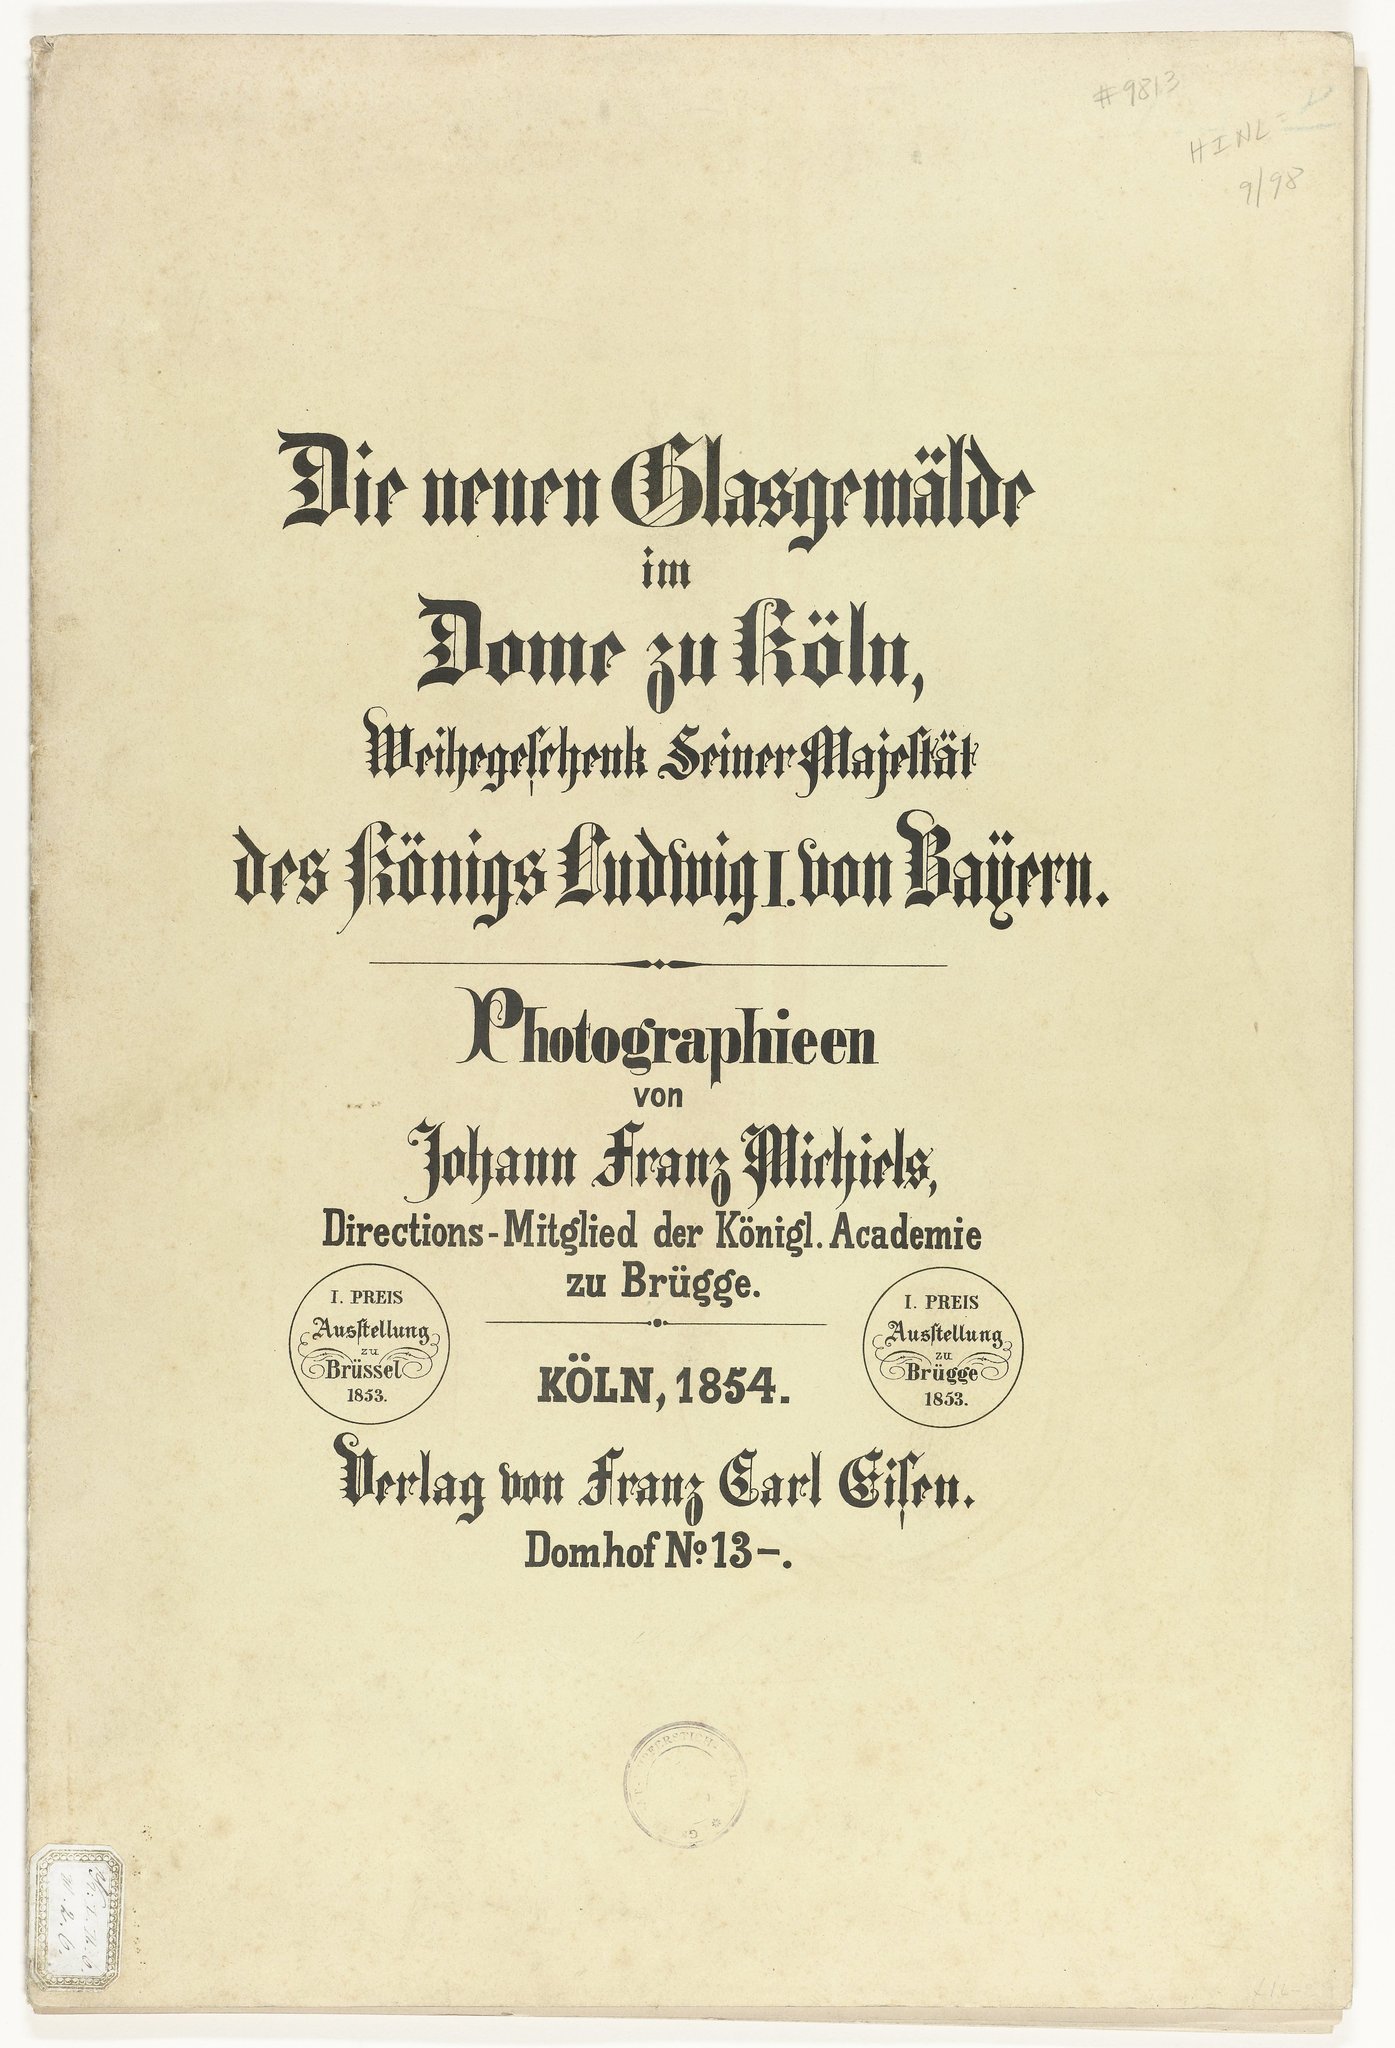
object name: photograph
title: Deel van een gebrandschilderd raam ontworpen door Max Emanuel Ainmiller, in de Dom van Keulen, Duitsland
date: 1849-1854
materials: photographic support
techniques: albumen print, lithograph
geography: cologne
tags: church-window, e.g. rose-window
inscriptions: inscription: ‘Carton von J. Hellweger’, inscription: ‘Die neuen Glas-Gemälde/ im Dome zu Köln,/ Weihe-Geschenk Seiner Majestät/ des Königs Ludwig I von Bayern.’, address: ‘Domhof No 13-.’, date: ‘1847.’, inscription: ‘Ornamentik von M. Ainmüller.’, number: ‘No 1.’, inscription: ‘Les Peintures sur verre/ dans la Cathédrale de Cologne,/ don de Sa Majesté Louis I,/ Roi de Bavière.’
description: Om de foto heen bevindt zich een ontwerp van het gehele raam. Deze foto maakt deel uit van een omslag met vijf foto's en één tekstblad.